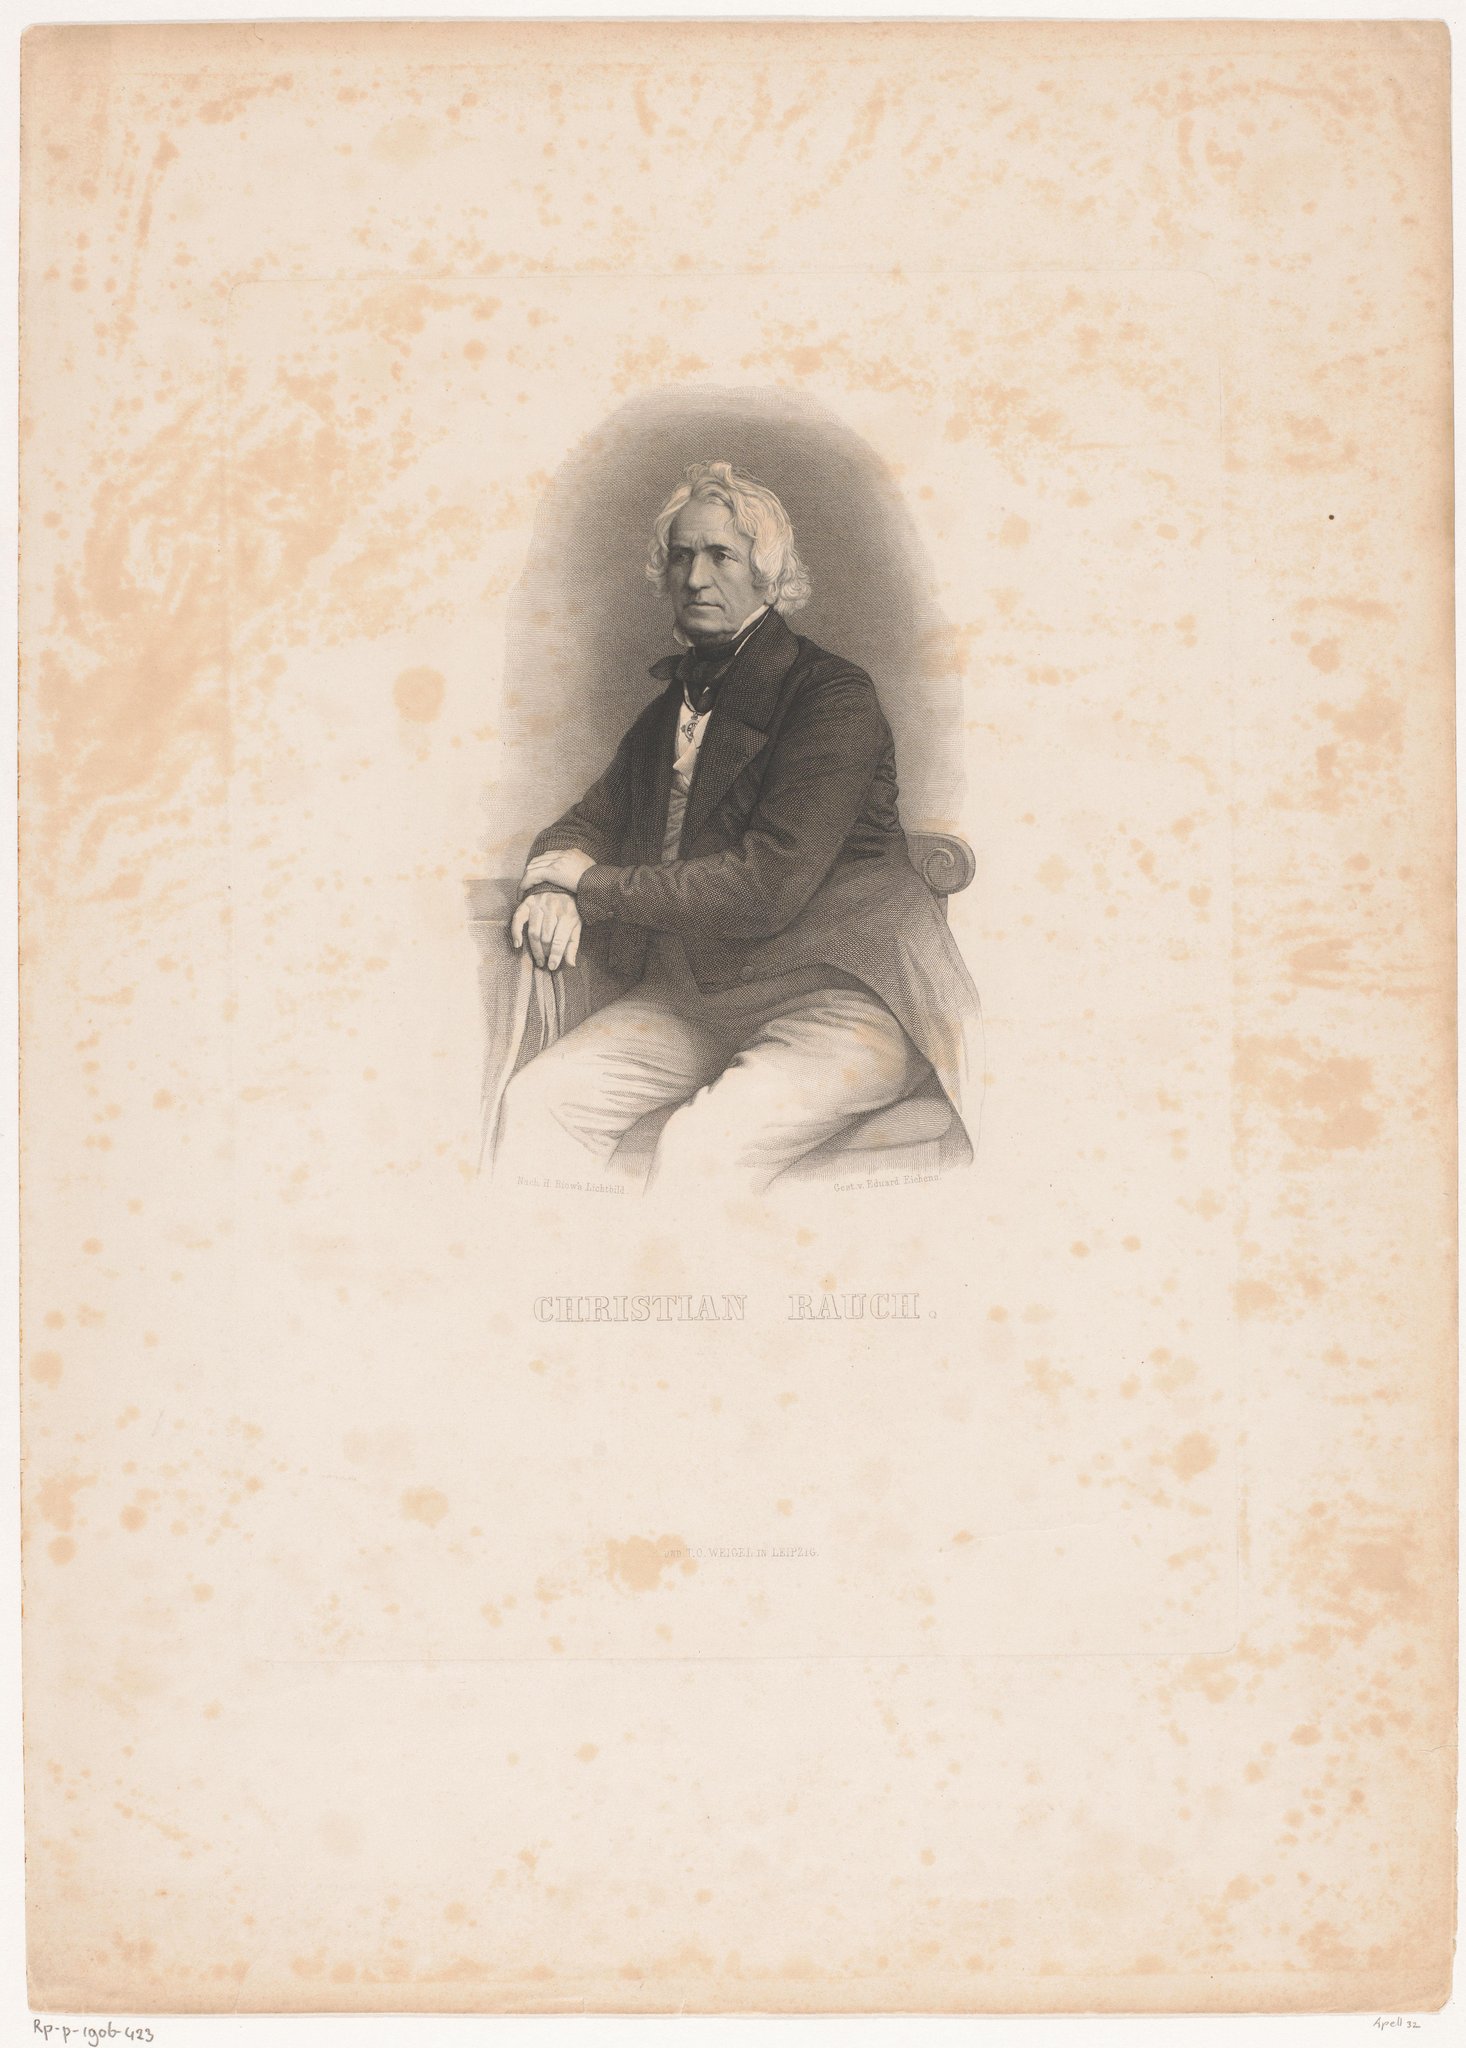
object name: print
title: Portret van Christian Daniel Rauch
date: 1814-1857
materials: paper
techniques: engraving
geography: leipzig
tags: sculptor, christian daniel rauch, historical persons, pendant, trinket, 'breloque'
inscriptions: collector's mark: Lugt 2228